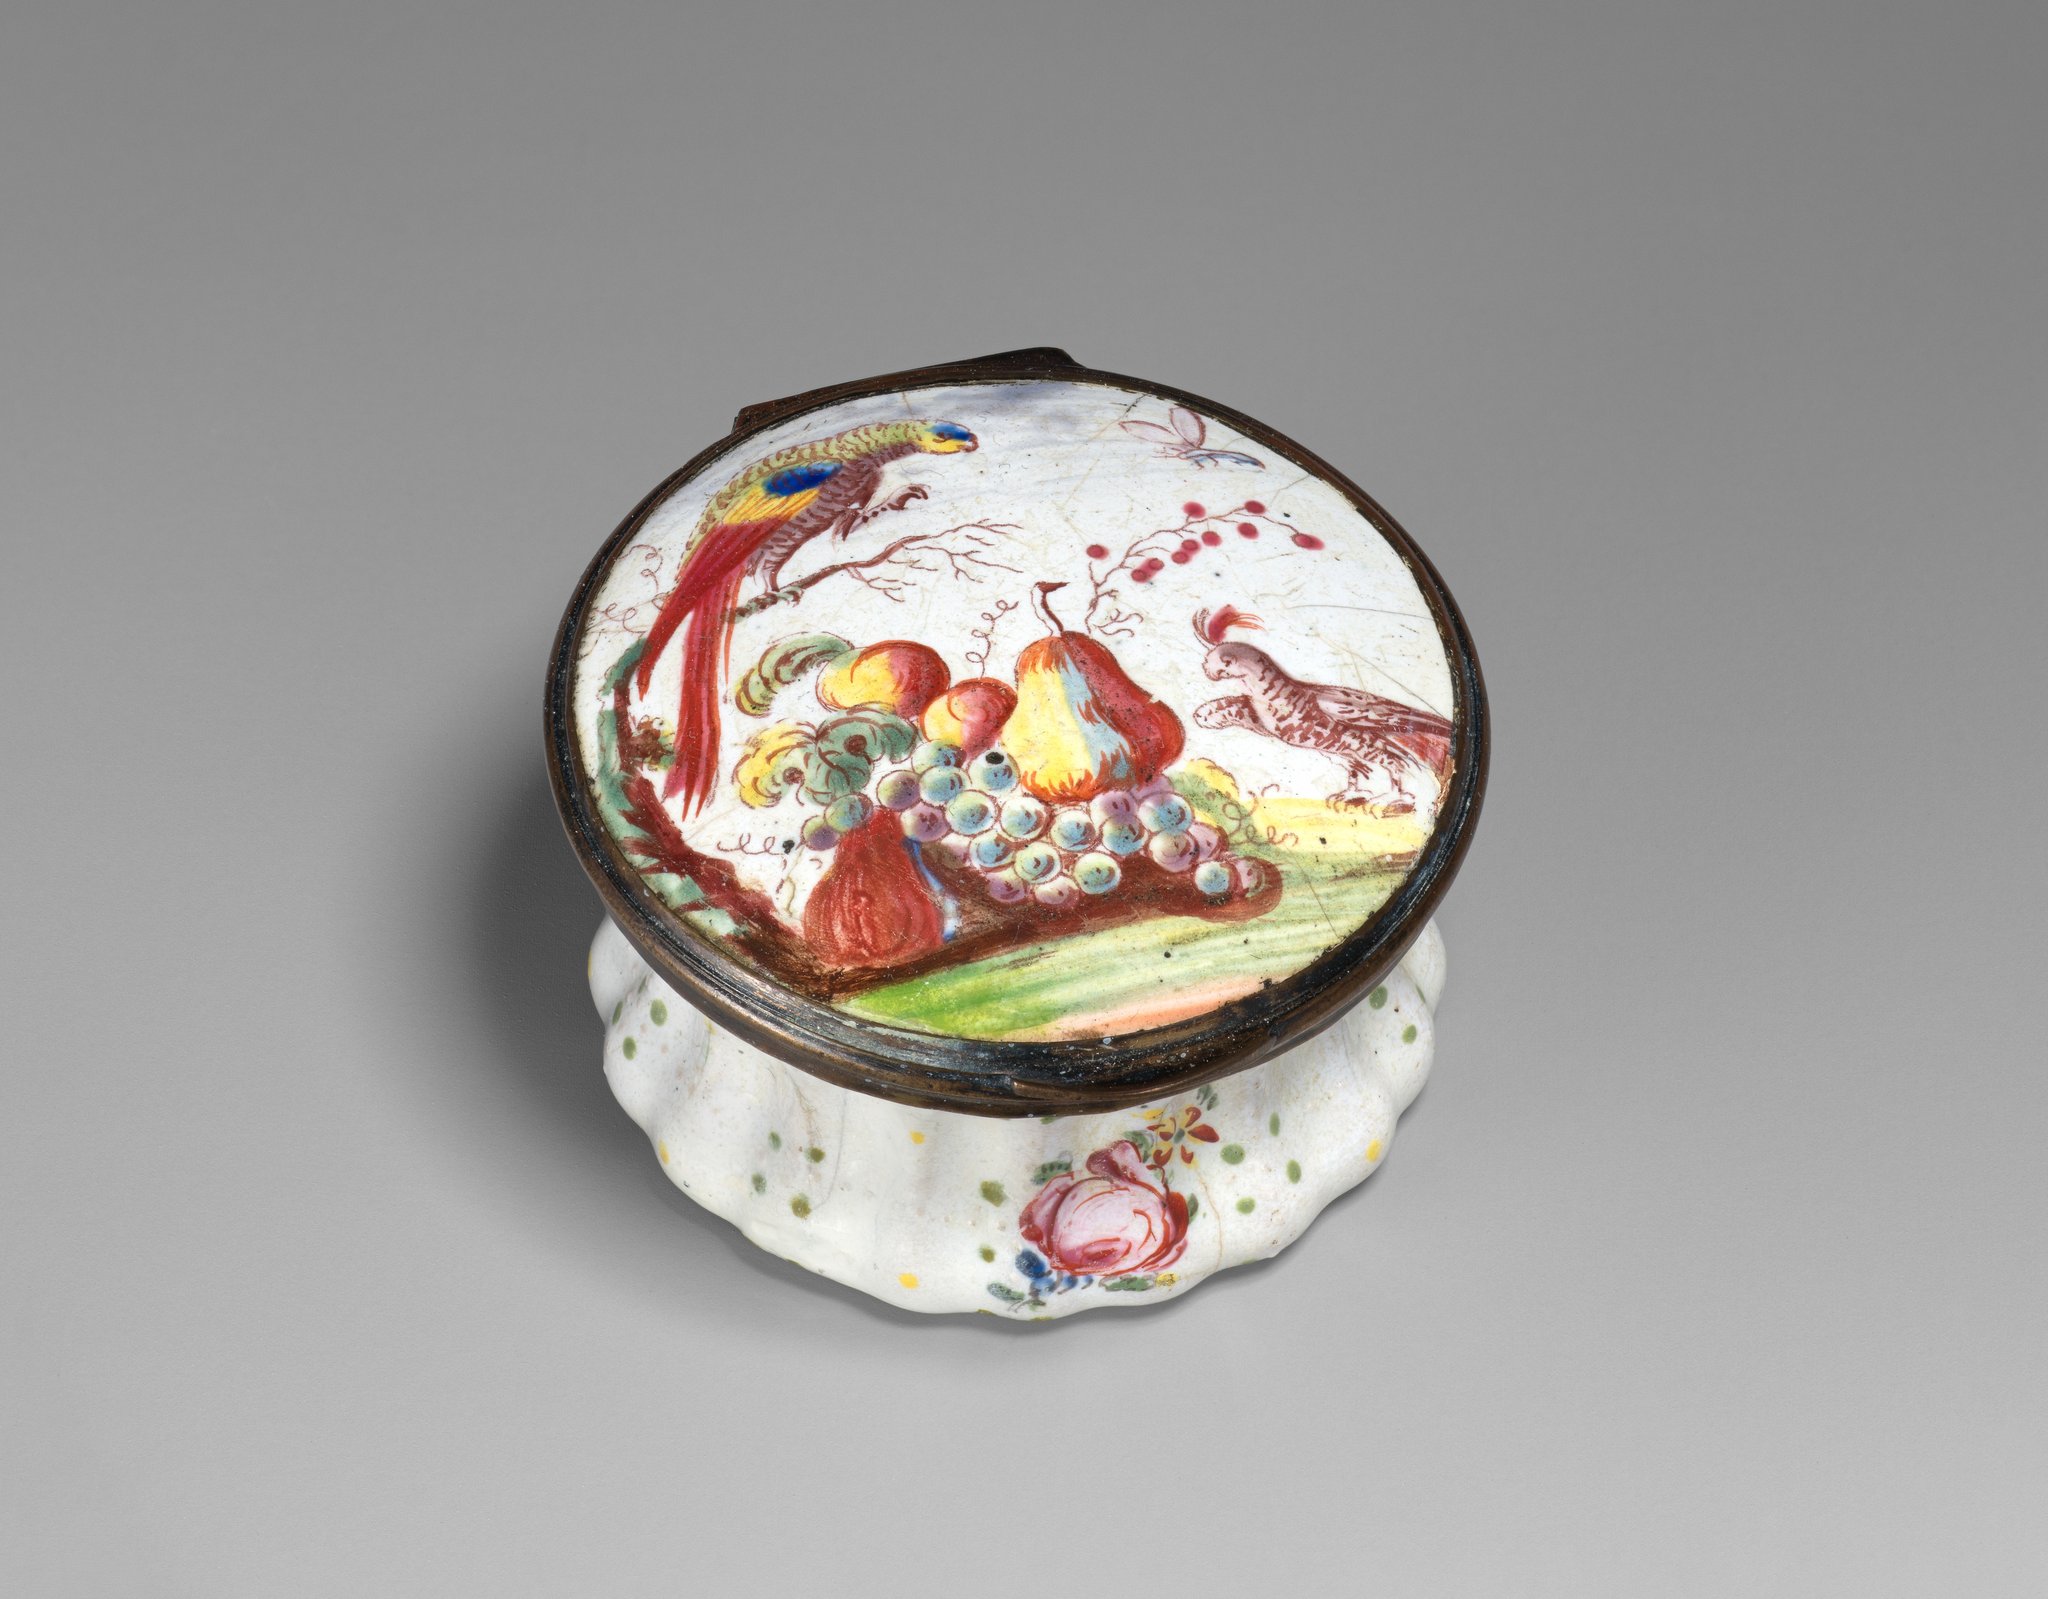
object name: snuffbox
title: Snuffbox with still life and parrots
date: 1770-1780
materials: copper, enamel